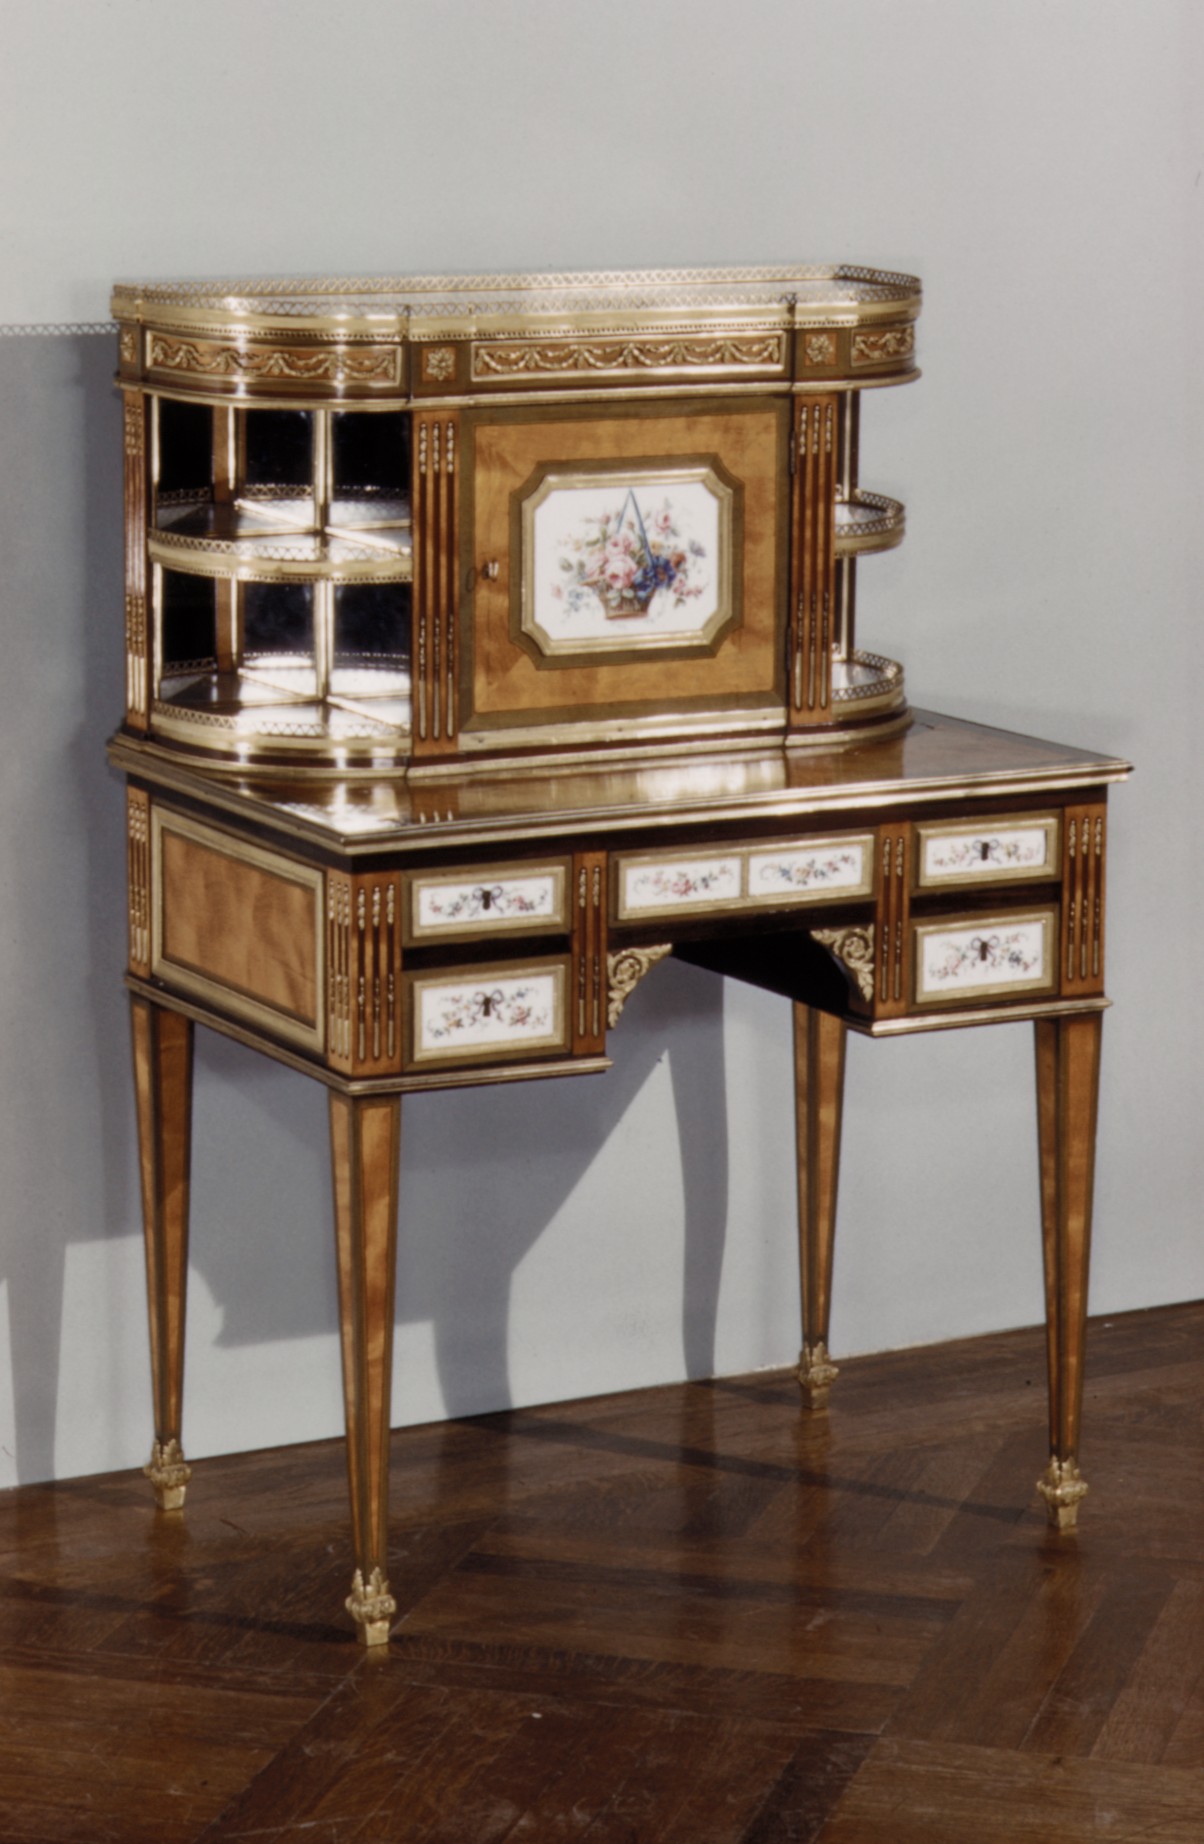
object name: desk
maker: sèvres manufactory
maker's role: manufactory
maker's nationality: french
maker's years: 1740-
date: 1790-1795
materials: marble, wood, soft paste porcelain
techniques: stain